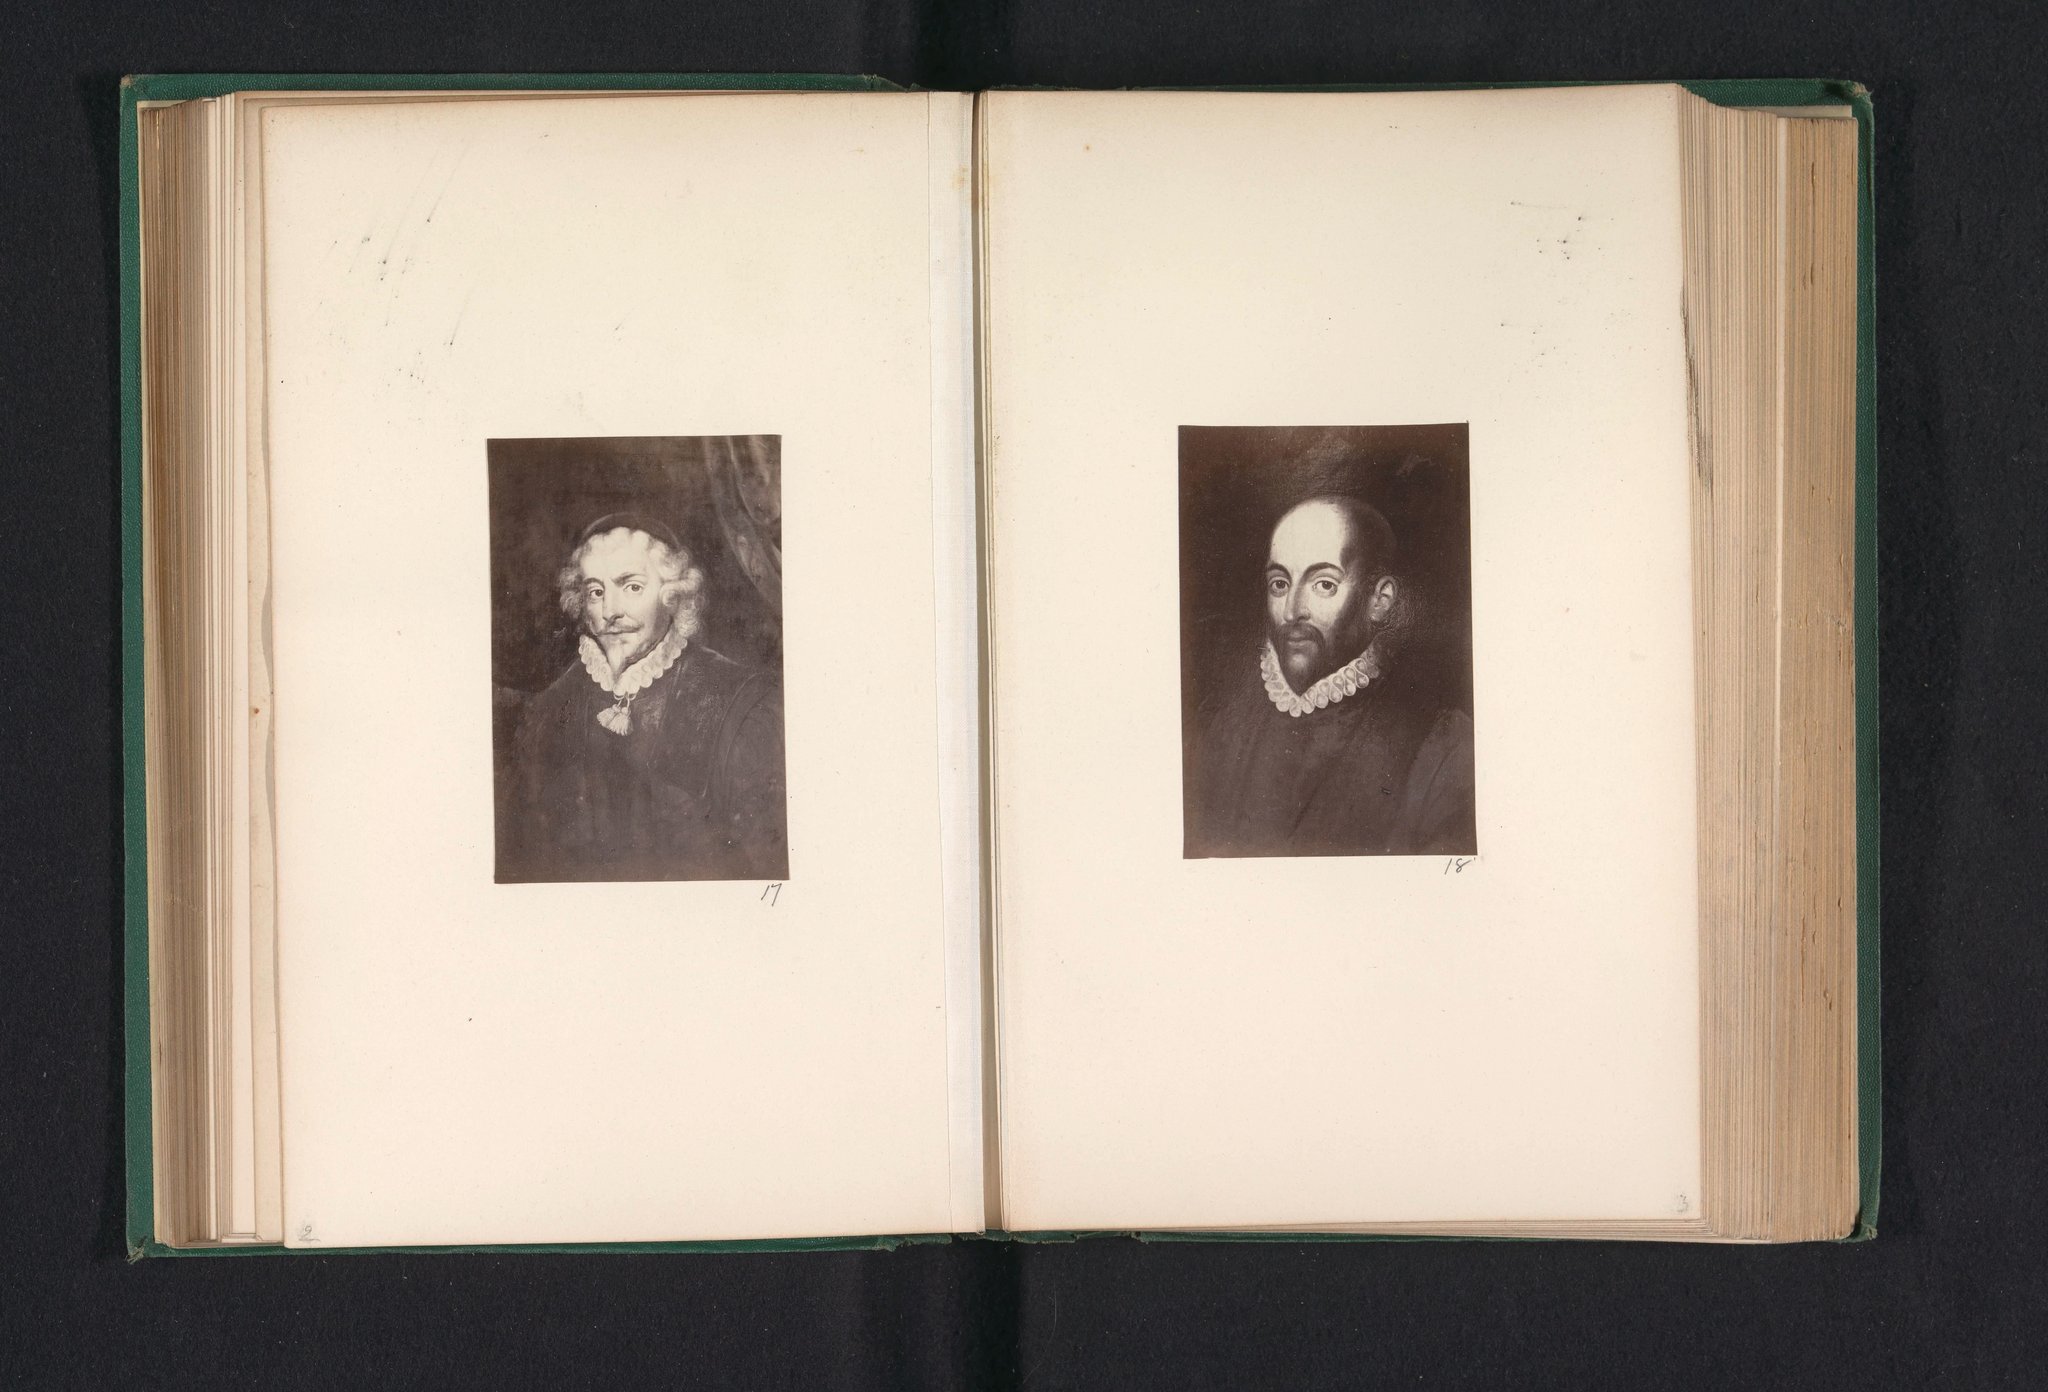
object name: photograph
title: Fotoreproductie van een schilderij, voorstellende een portret van William Spang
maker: thomas annan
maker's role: fotograaf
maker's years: 1829-1887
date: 1863-1868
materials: photographic support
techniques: albumen print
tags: historical persons (portraits and scenes from the life) (+ (full) bust portrait)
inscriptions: number: ‘18’